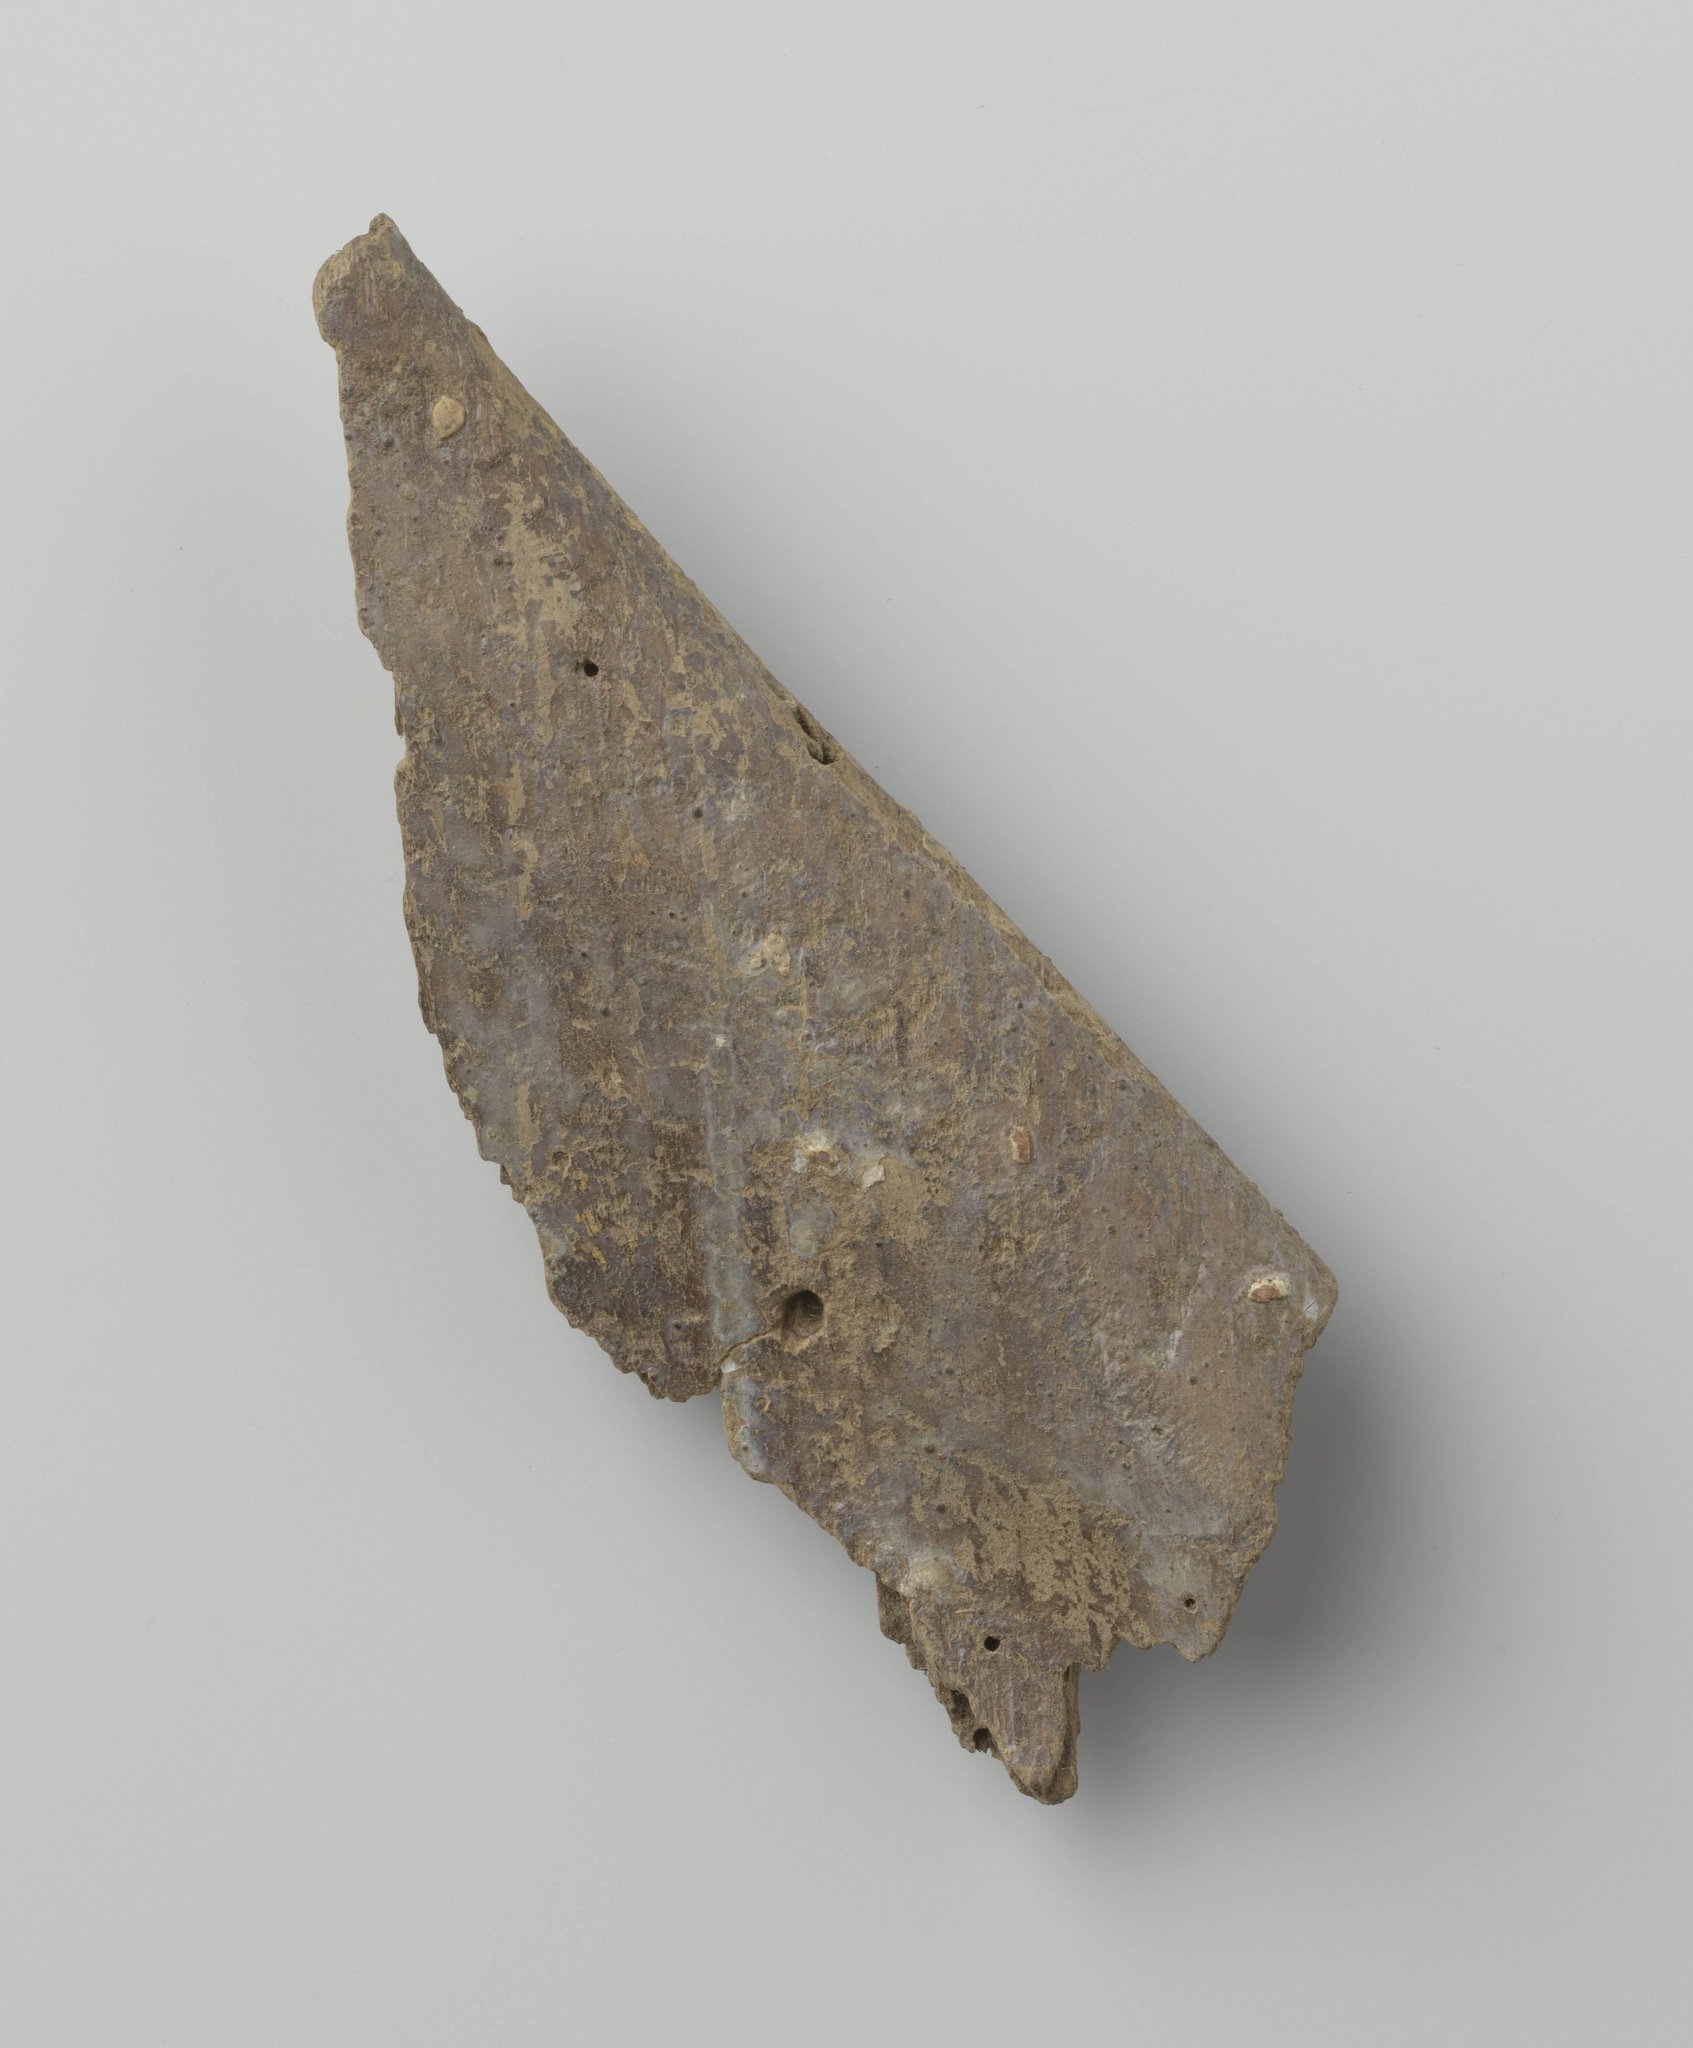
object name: fragment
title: Fragment; (mogelijk) behorend tot het retabel van Soest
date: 1475-1499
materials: wood